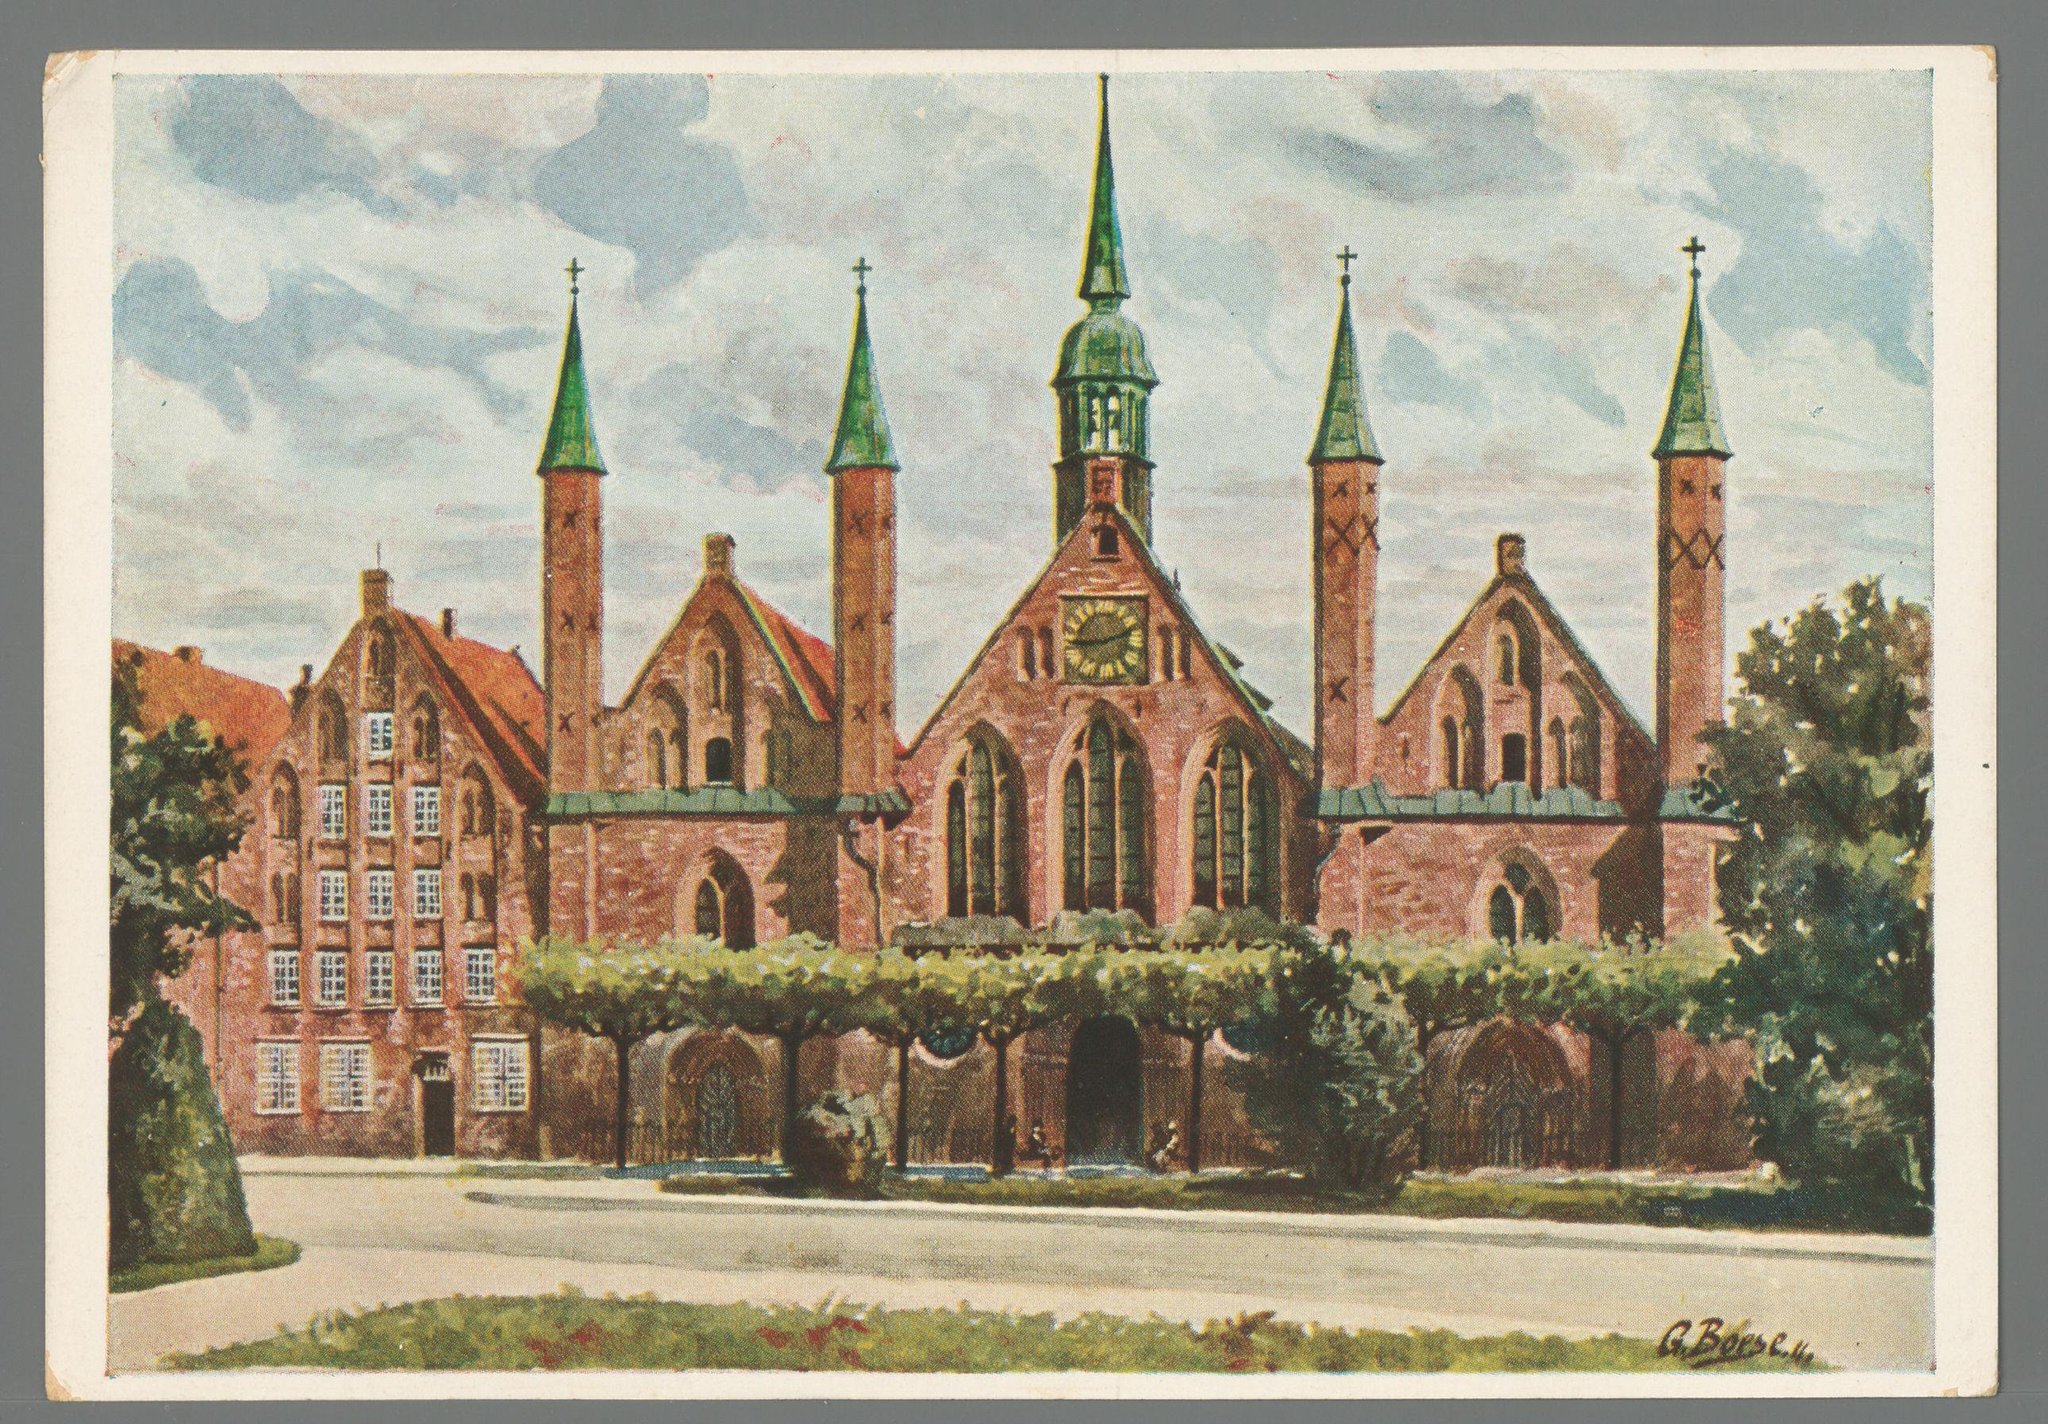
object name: photomechanical print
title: Lübeck. Heiligengeist-Hospital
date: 1911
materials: cardboard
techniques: color autotype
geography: lübeck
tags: hospital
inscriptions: date